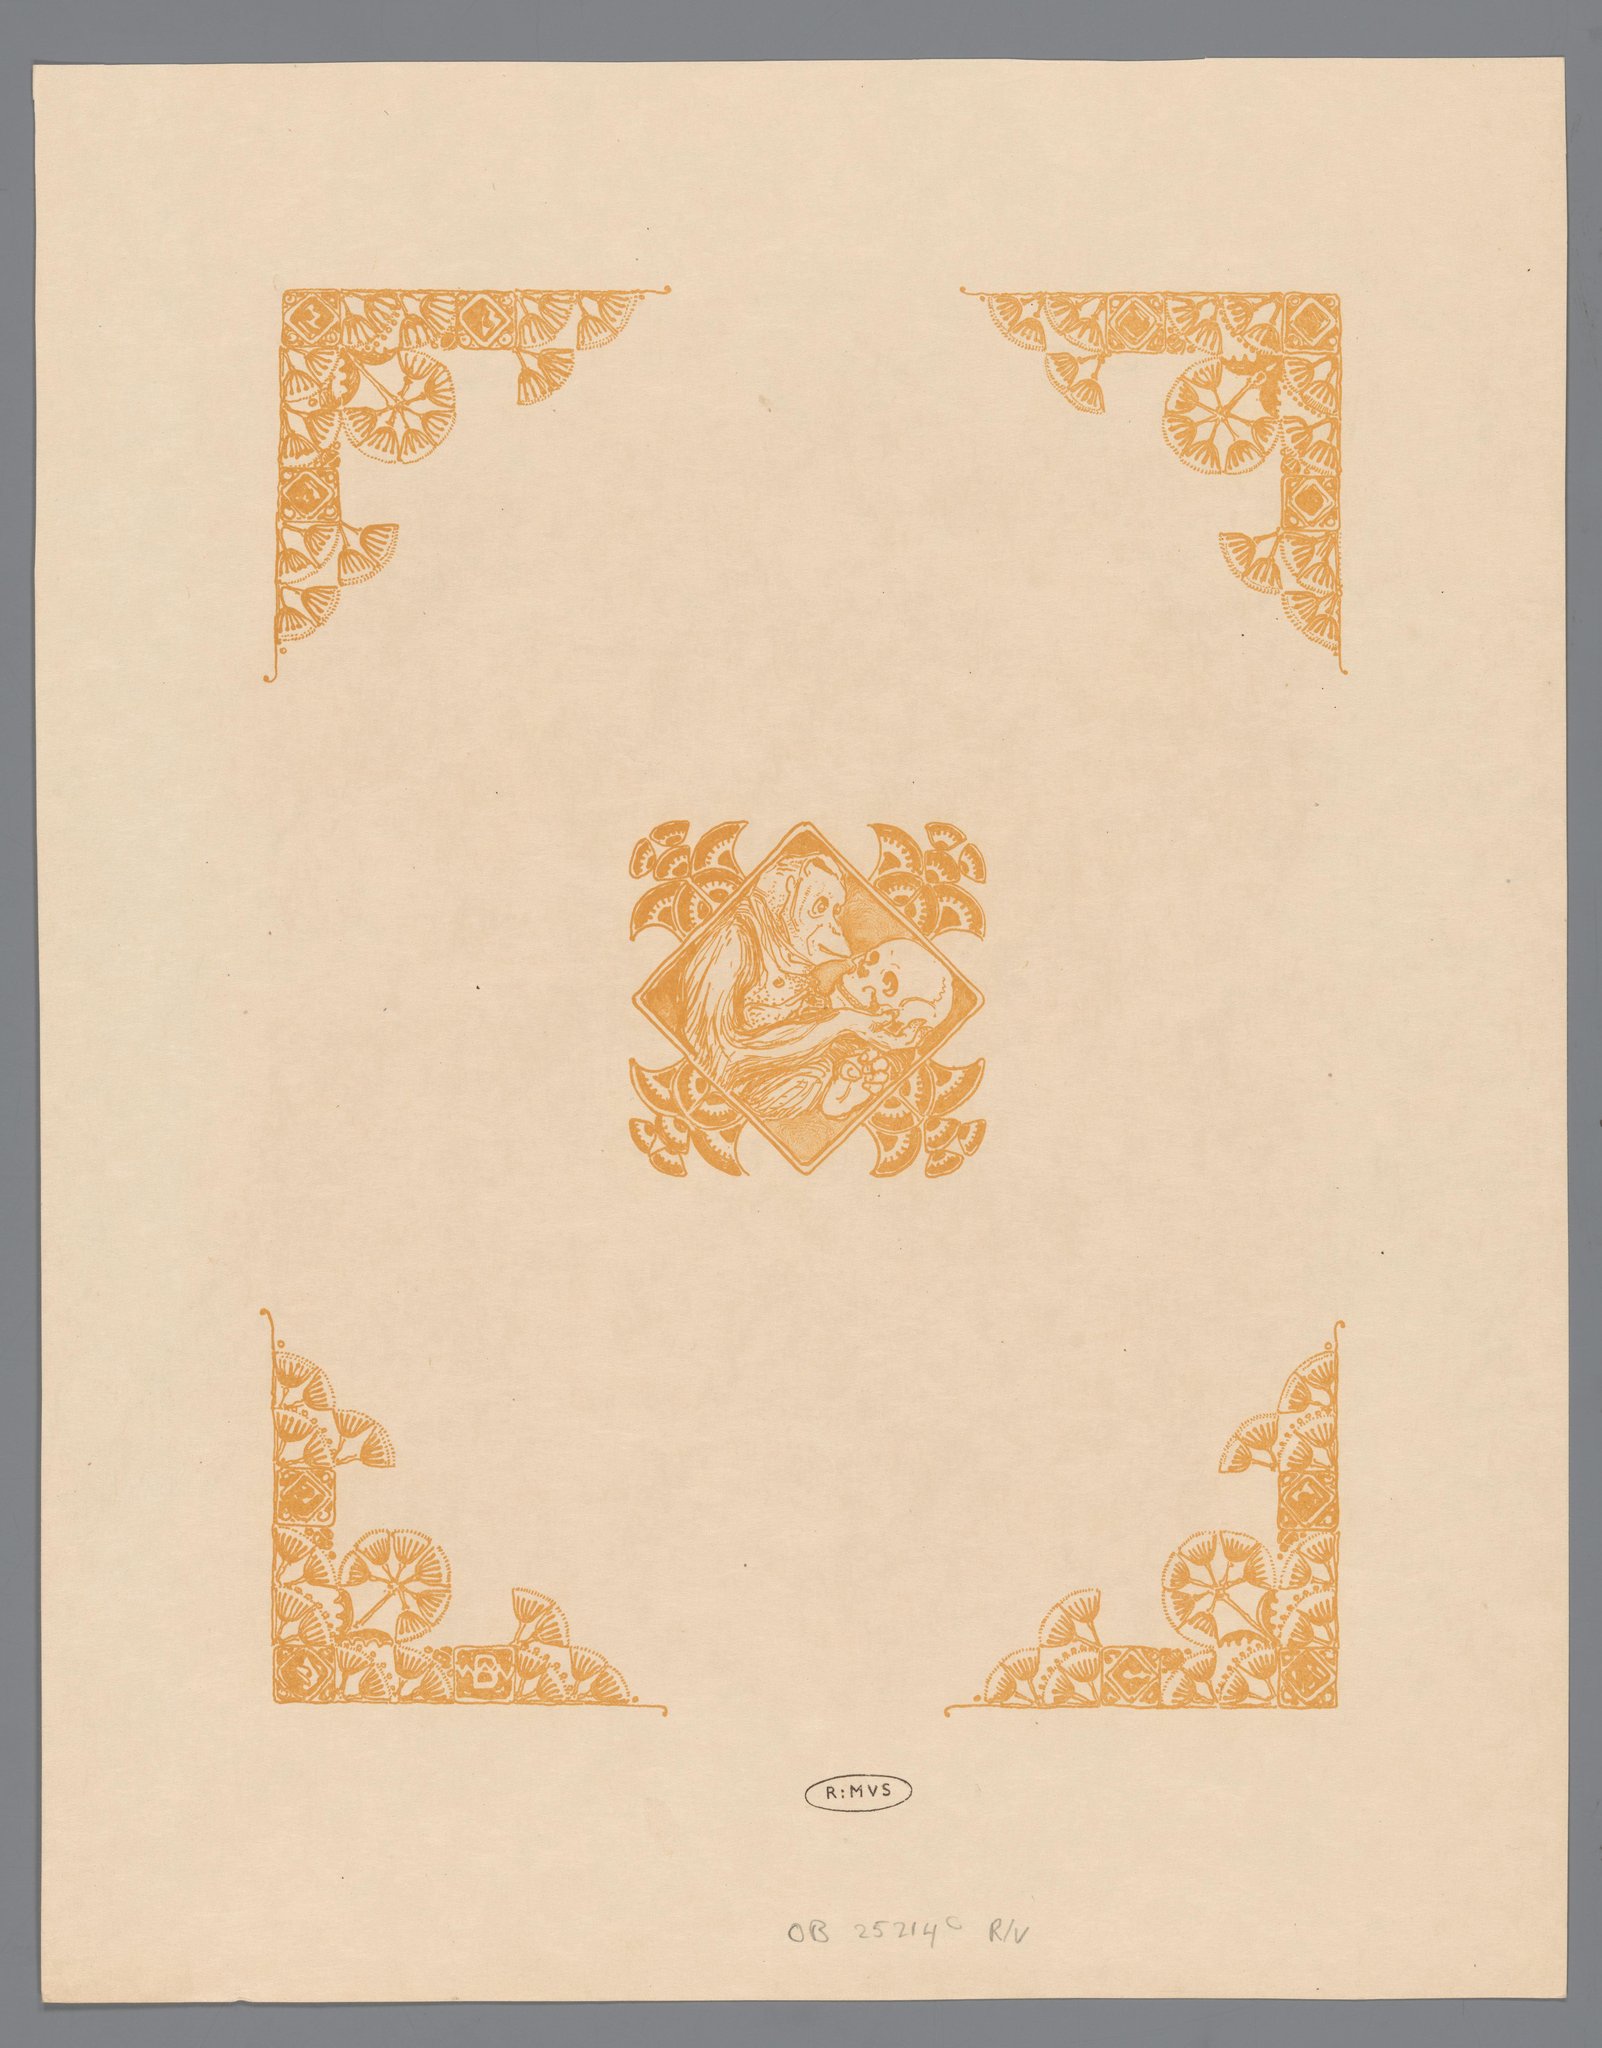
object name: print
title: Ornamentiek en een aap met een schedel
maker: bernard willem wierink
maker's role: draughtsman, print maker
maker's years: 1856-1939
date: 1910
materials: paper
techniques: lithograph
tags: fable of reynard the fox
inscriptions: collector's mark: Lugt 2228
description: Prent gebruikt in: Streuvels, Stijn (Frank Lateur). Reinaert de Vos naar verschillende uitgaven van het middeleeuwsche epos. Amsterdam: L.J. Veen, 1910.